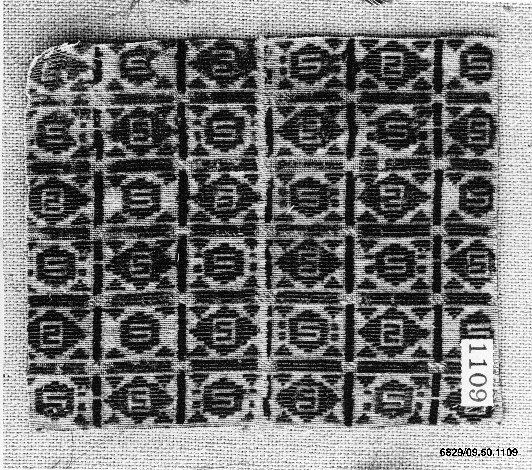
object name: textile fragment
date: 1801-1900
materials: linen, metal thread, silk, velvet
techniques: brocade, weave, voiding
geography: india